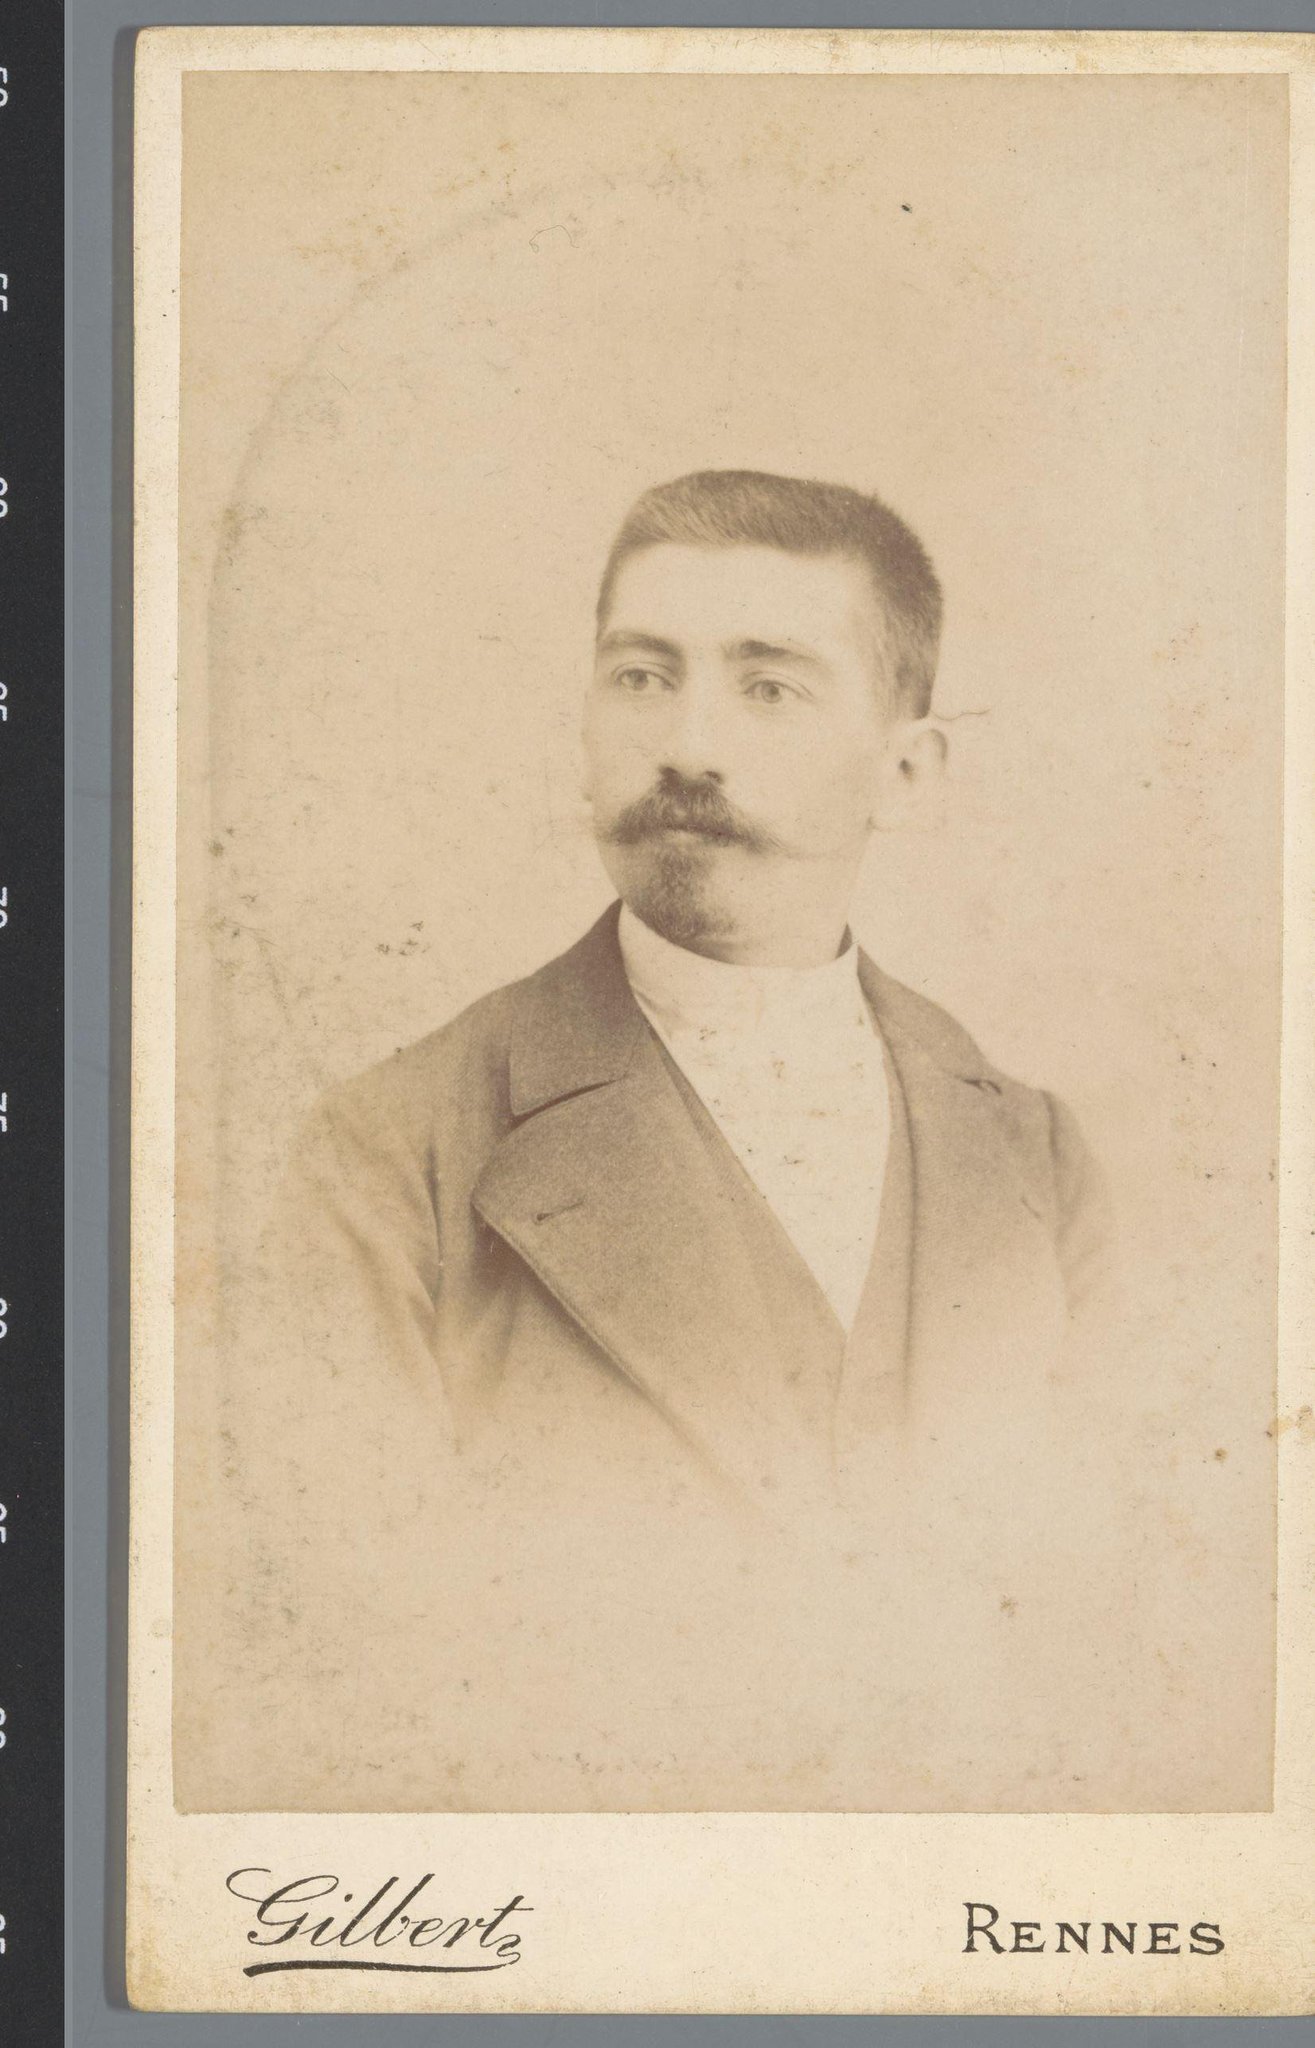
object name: photograph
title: Portret van een onbekende man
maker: raphaël eugène gilbert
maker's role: fotograaf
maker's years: 1862-1913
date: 1890-1901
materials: cardboard, paper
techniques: albumen print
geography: rennes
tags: adult man, anonymous historical person portrayed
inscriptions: address: ‘Rue de l'Alma, 2/ près la Caserne du Colombier/ Rennes.’, inscription: ‘On opère tous les jours et par tous/ les temps avec la même réussite/ Les Clichés sont conservés./ D. HUTINET. PARIS.’